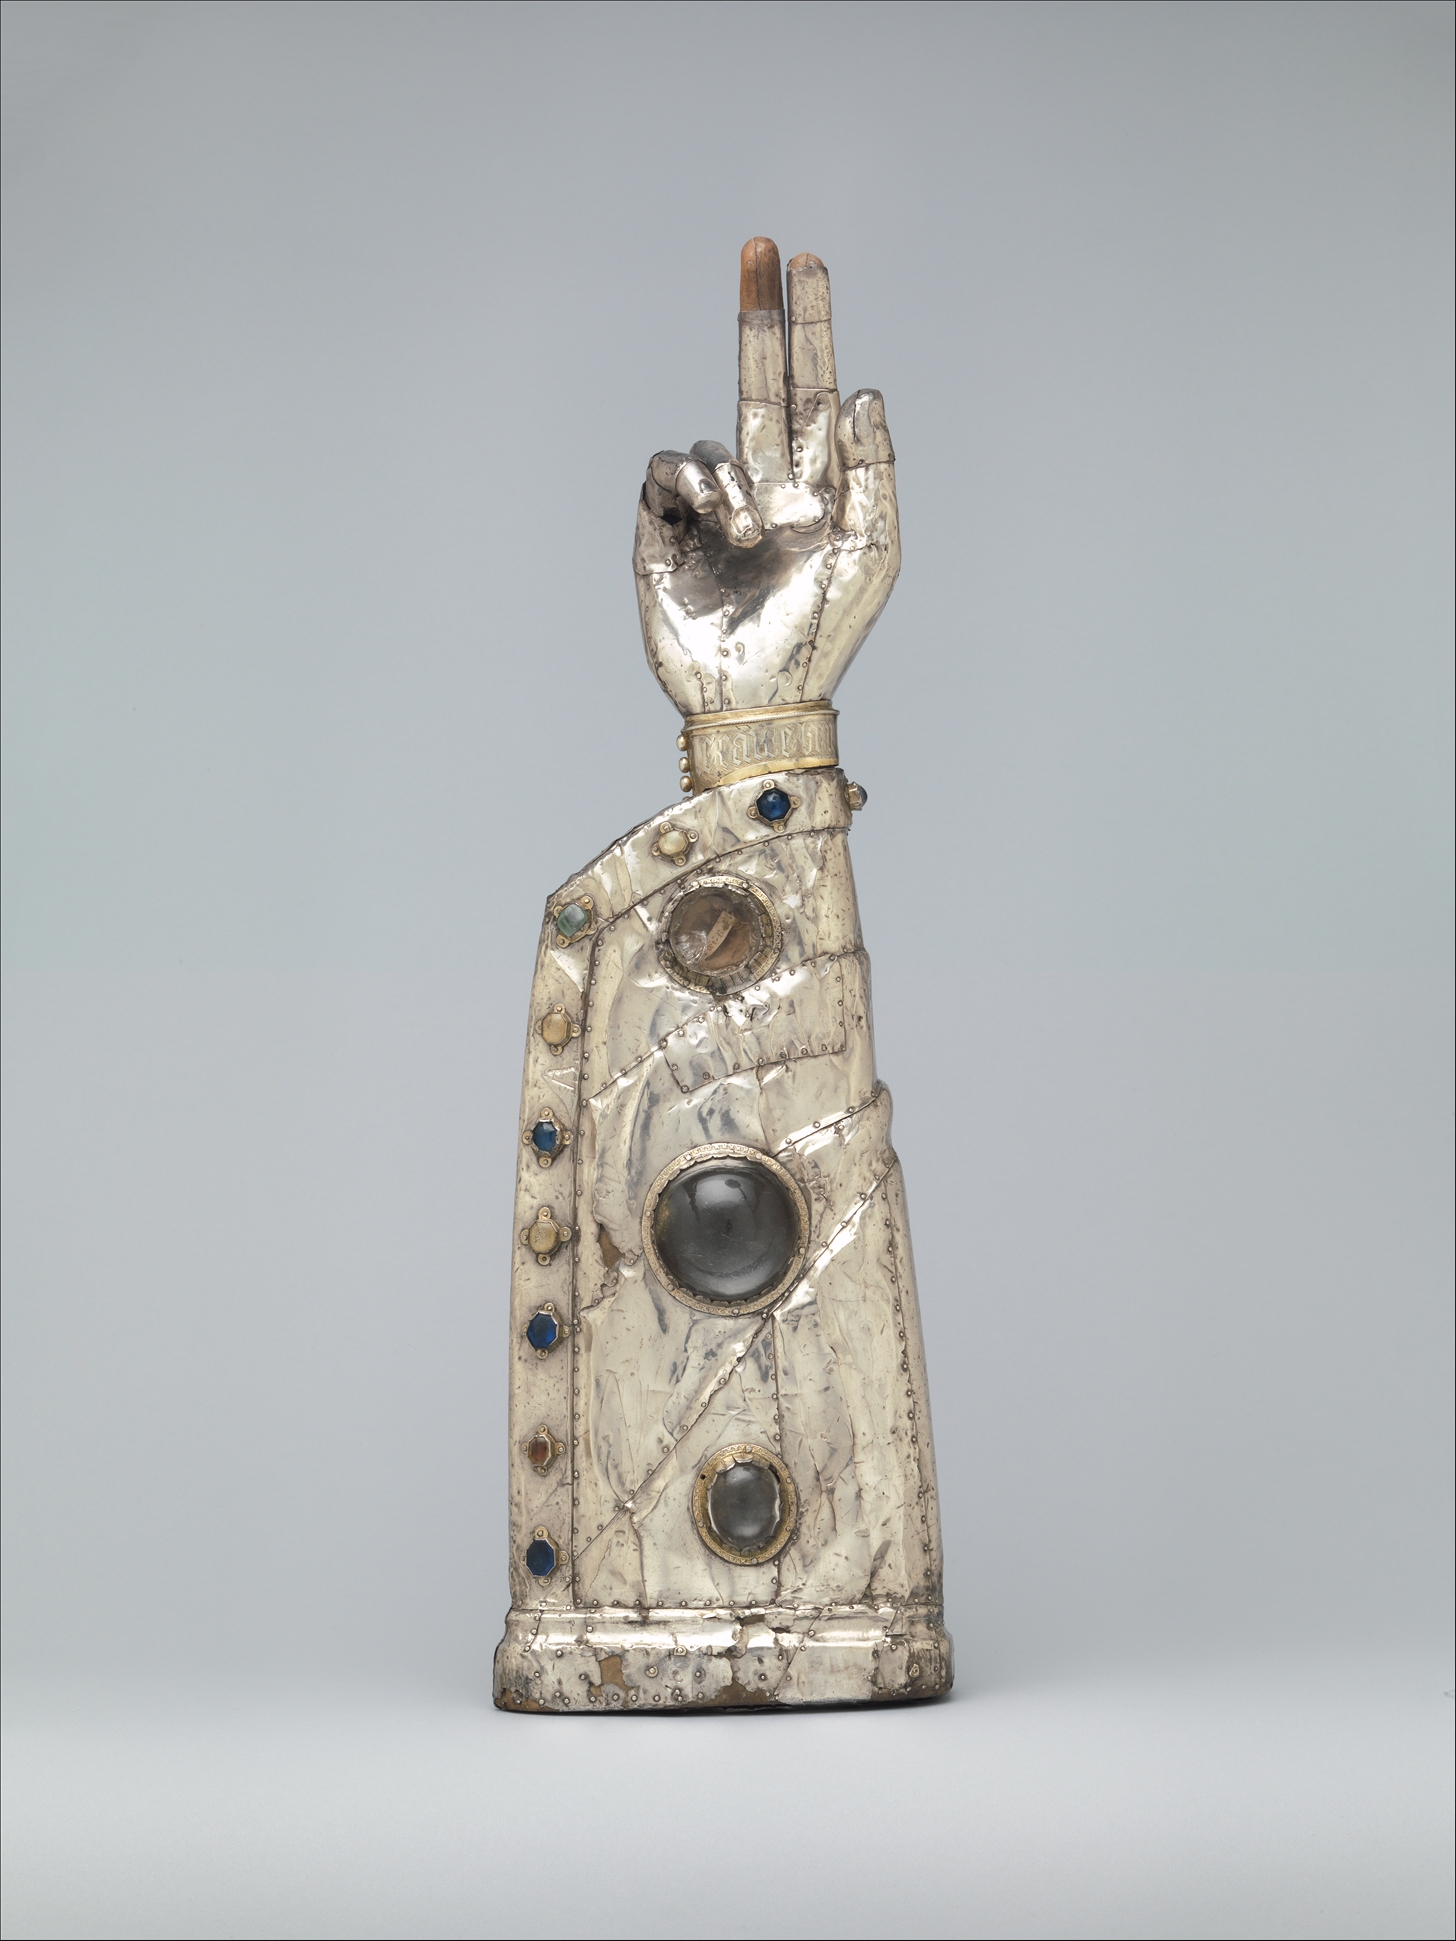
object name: reliquary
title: Arm Reliquary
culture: french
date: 1201-1300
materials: glass, quartz, silver, silver gilt, wood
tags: hands